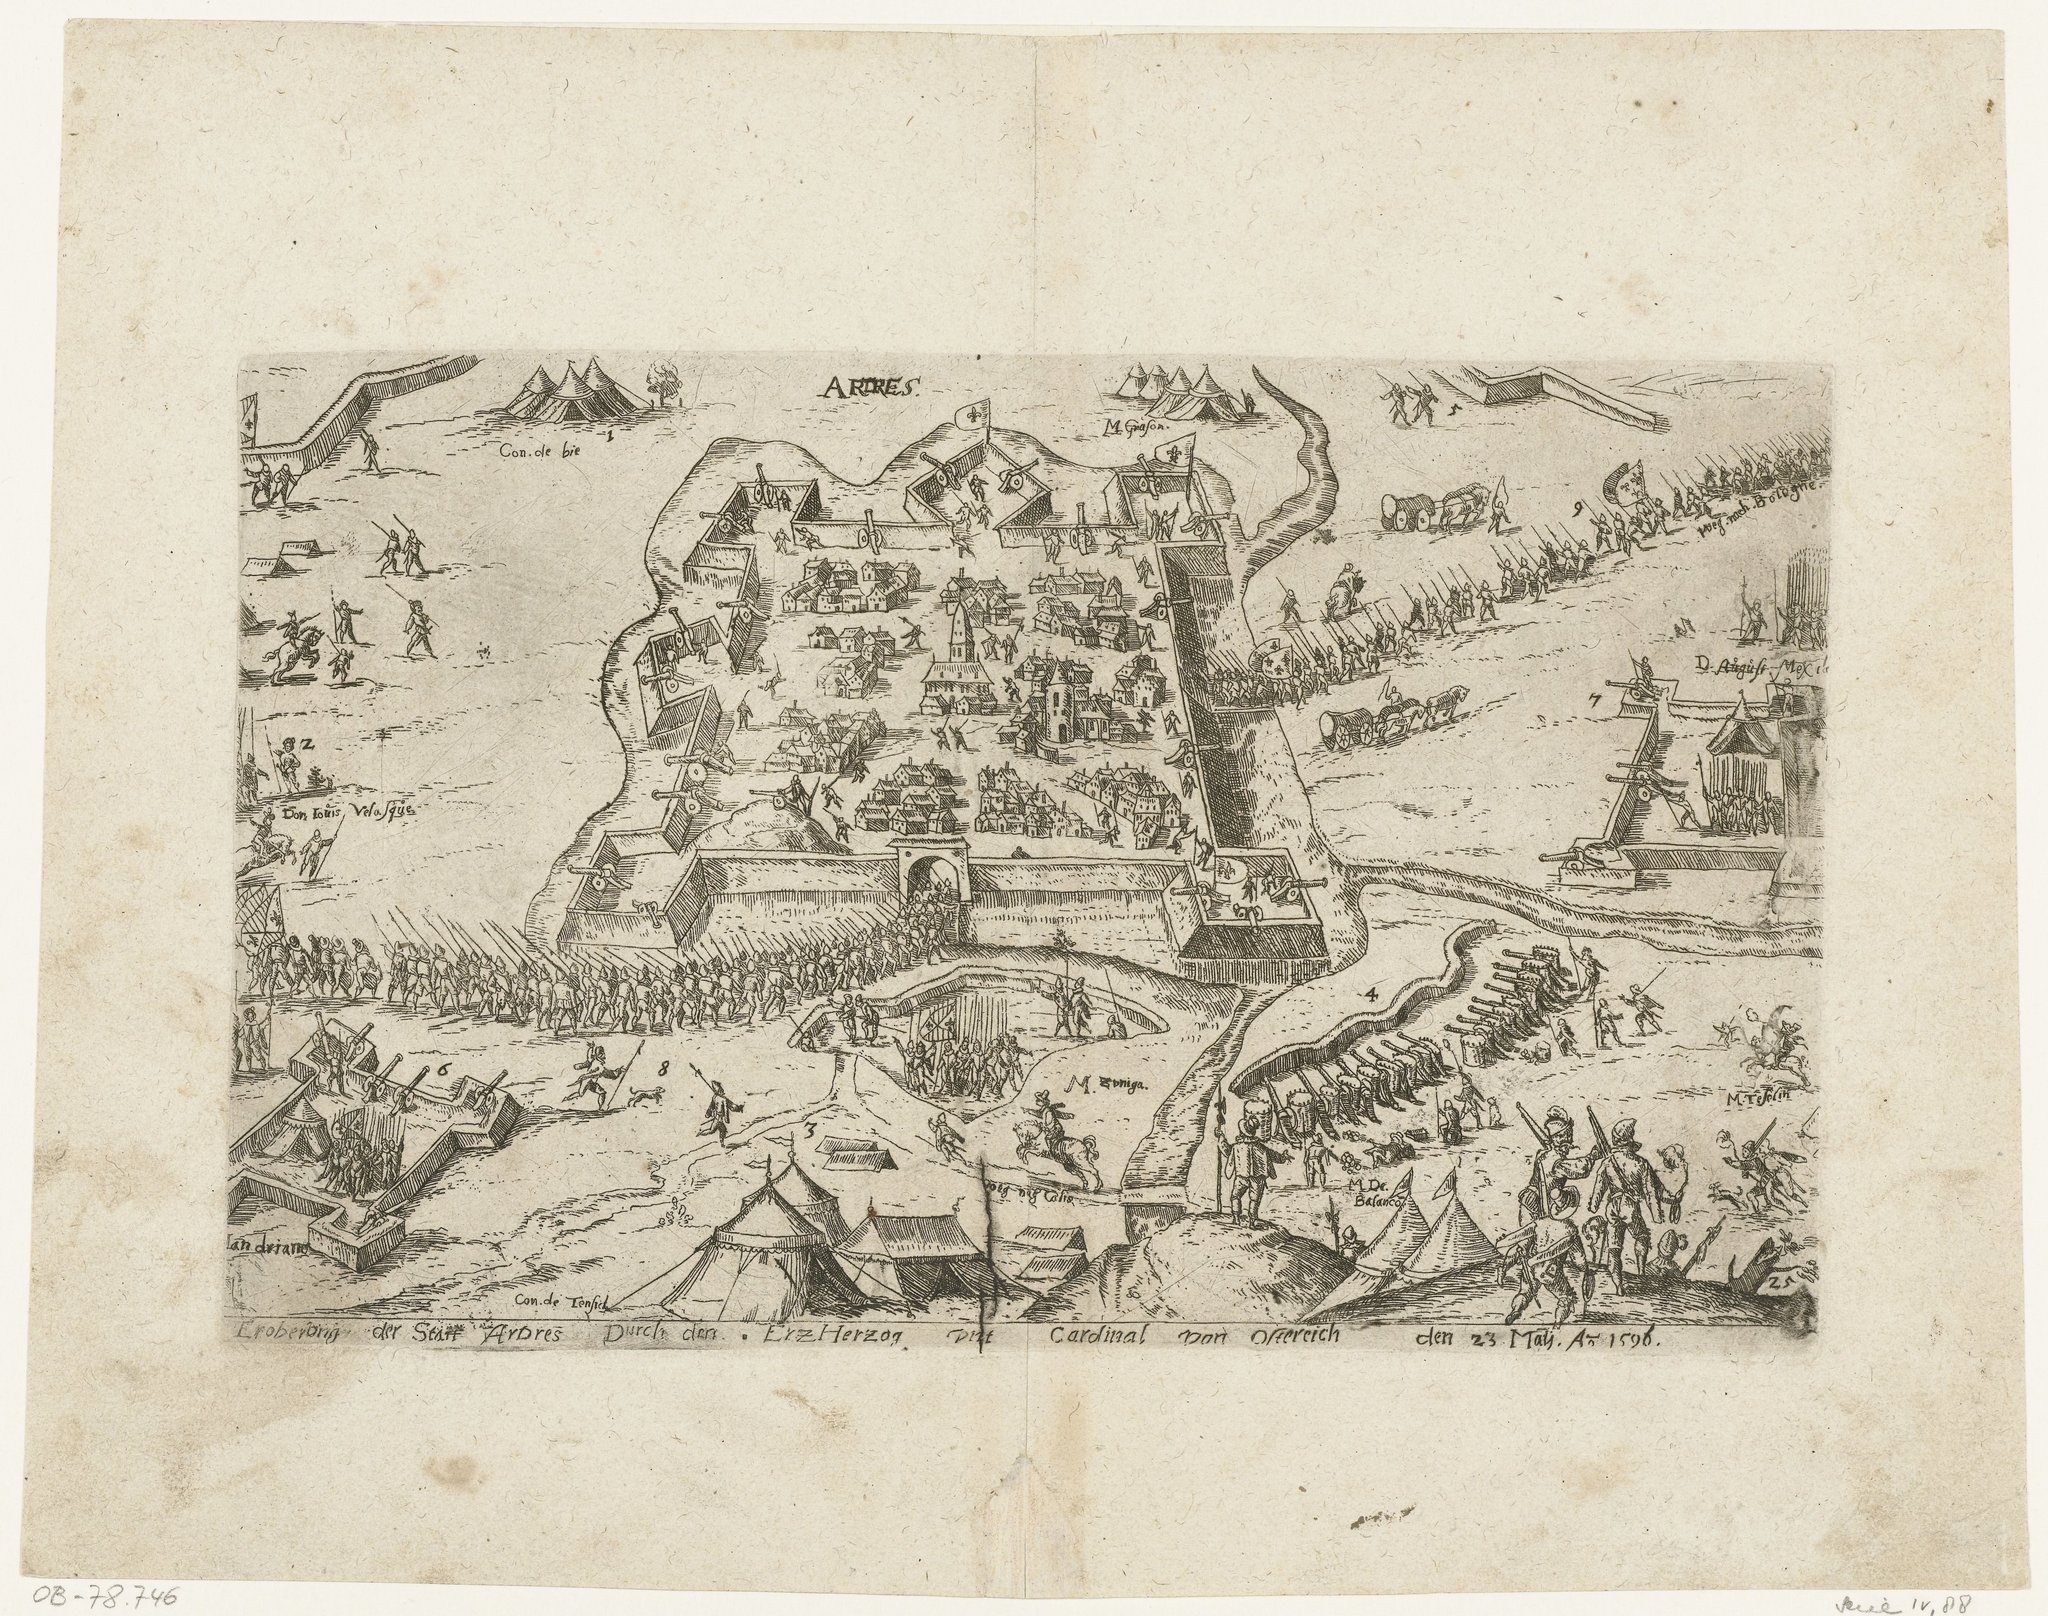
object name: print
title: Eroberung der Statt Ardres Durch den ErzHerzog unt Cardinal von Osterich den 23 May Ao. 1596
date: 1596-1598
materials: paper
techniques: etching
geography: germany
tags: brussels, albrecht aartshertog van oostenrijk, capture of city (after the siege)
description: Verovering van Ardres door Albrecht van Oostenrijk, 23 mei 1596. De Franse troepen verlaten de omsingelde stad. Met onderschrift van 1 regel in het Duits. Ongenummerd. Gedeeltelijke kopie naar de prent van Hogenberg.